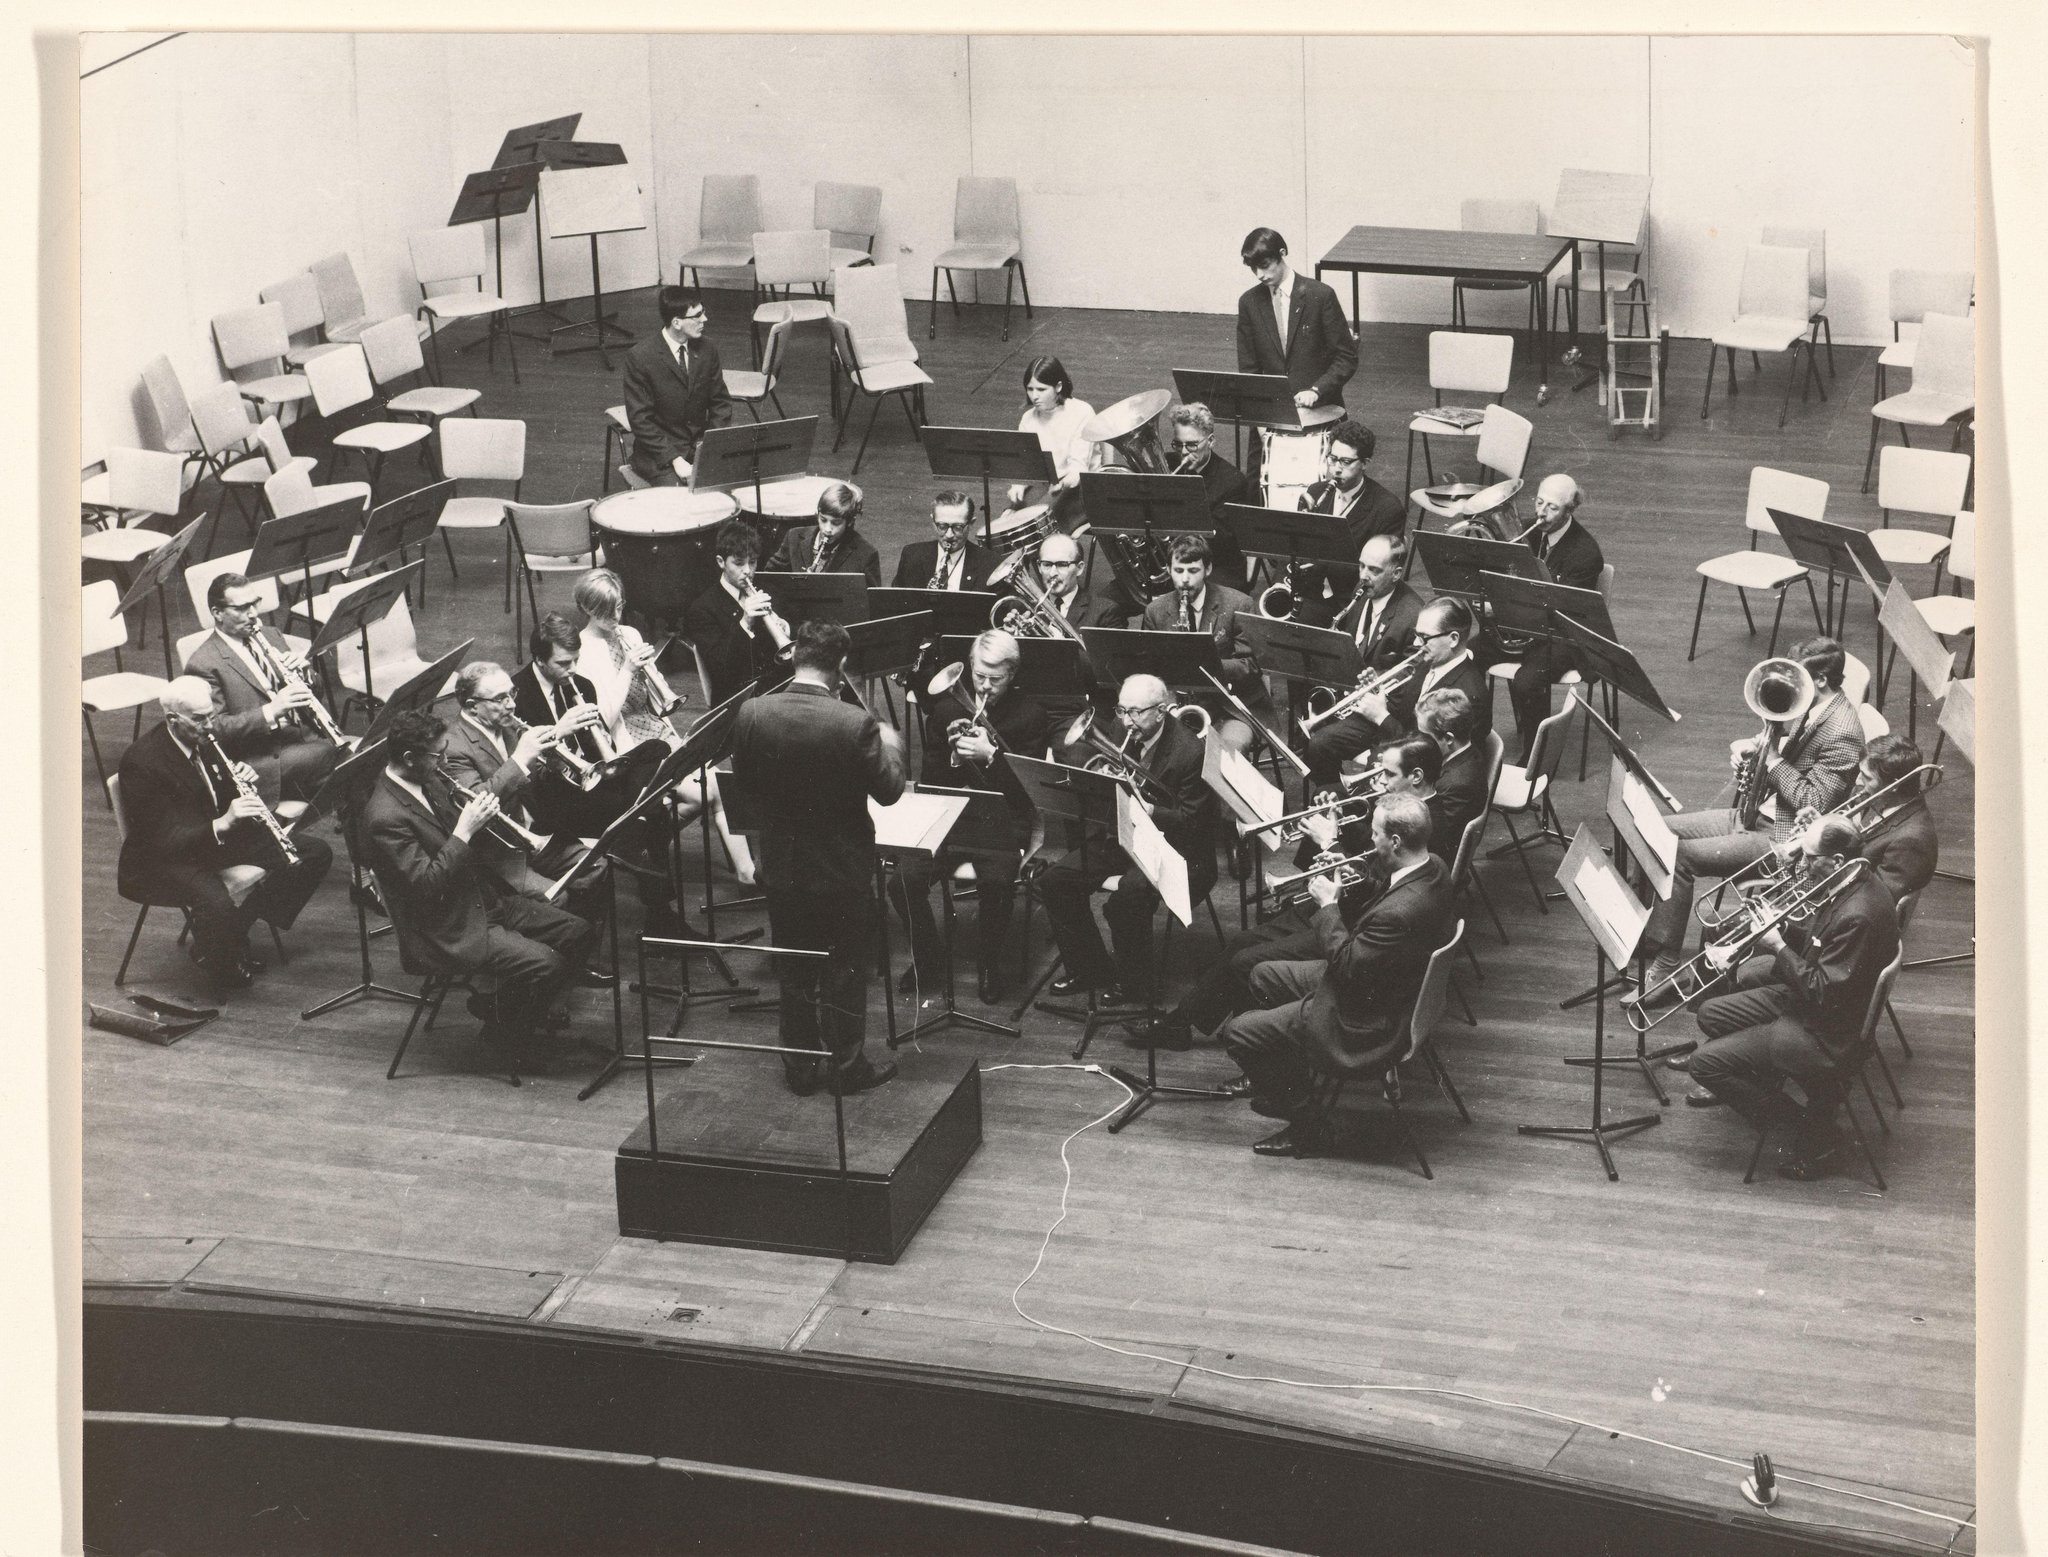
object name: photograph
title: Muziekgezelschap 'Crescendo' in een zaal in Tilburg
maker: Anonymous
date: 1968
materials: photographic support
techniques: gelatin silver print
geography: tilburg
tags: making music; musician with instrument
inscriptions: inscription: ‘Tilburg 1968’